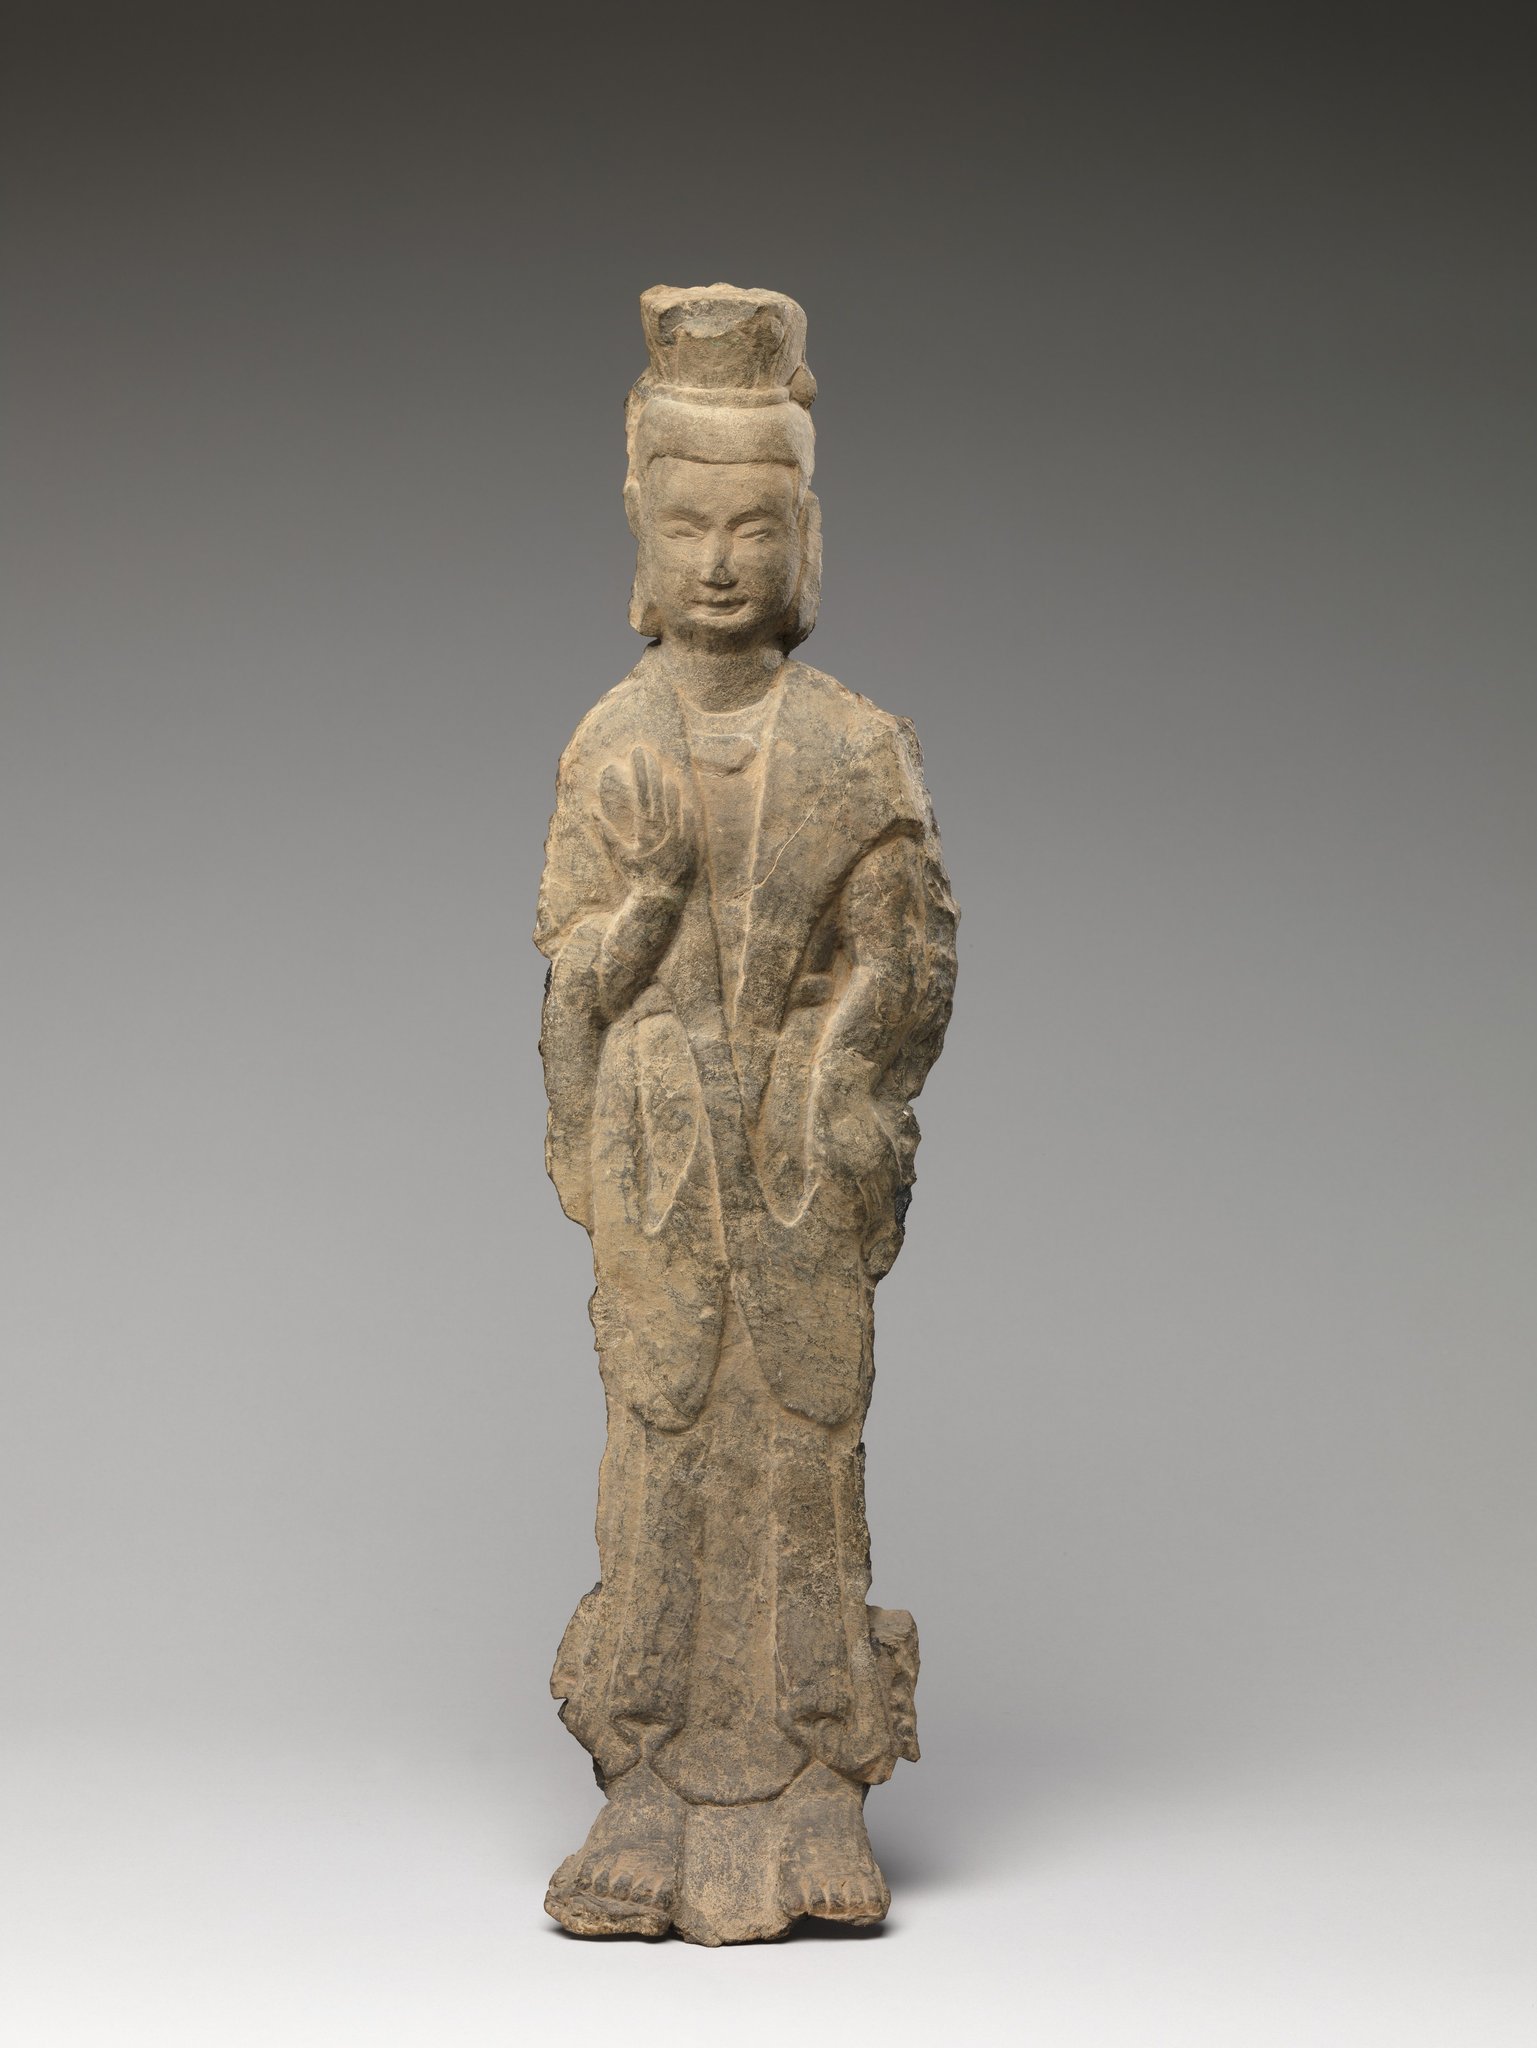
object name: figure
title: Attendant bodhisattva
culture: chinese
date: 501-533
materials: limestone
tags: men